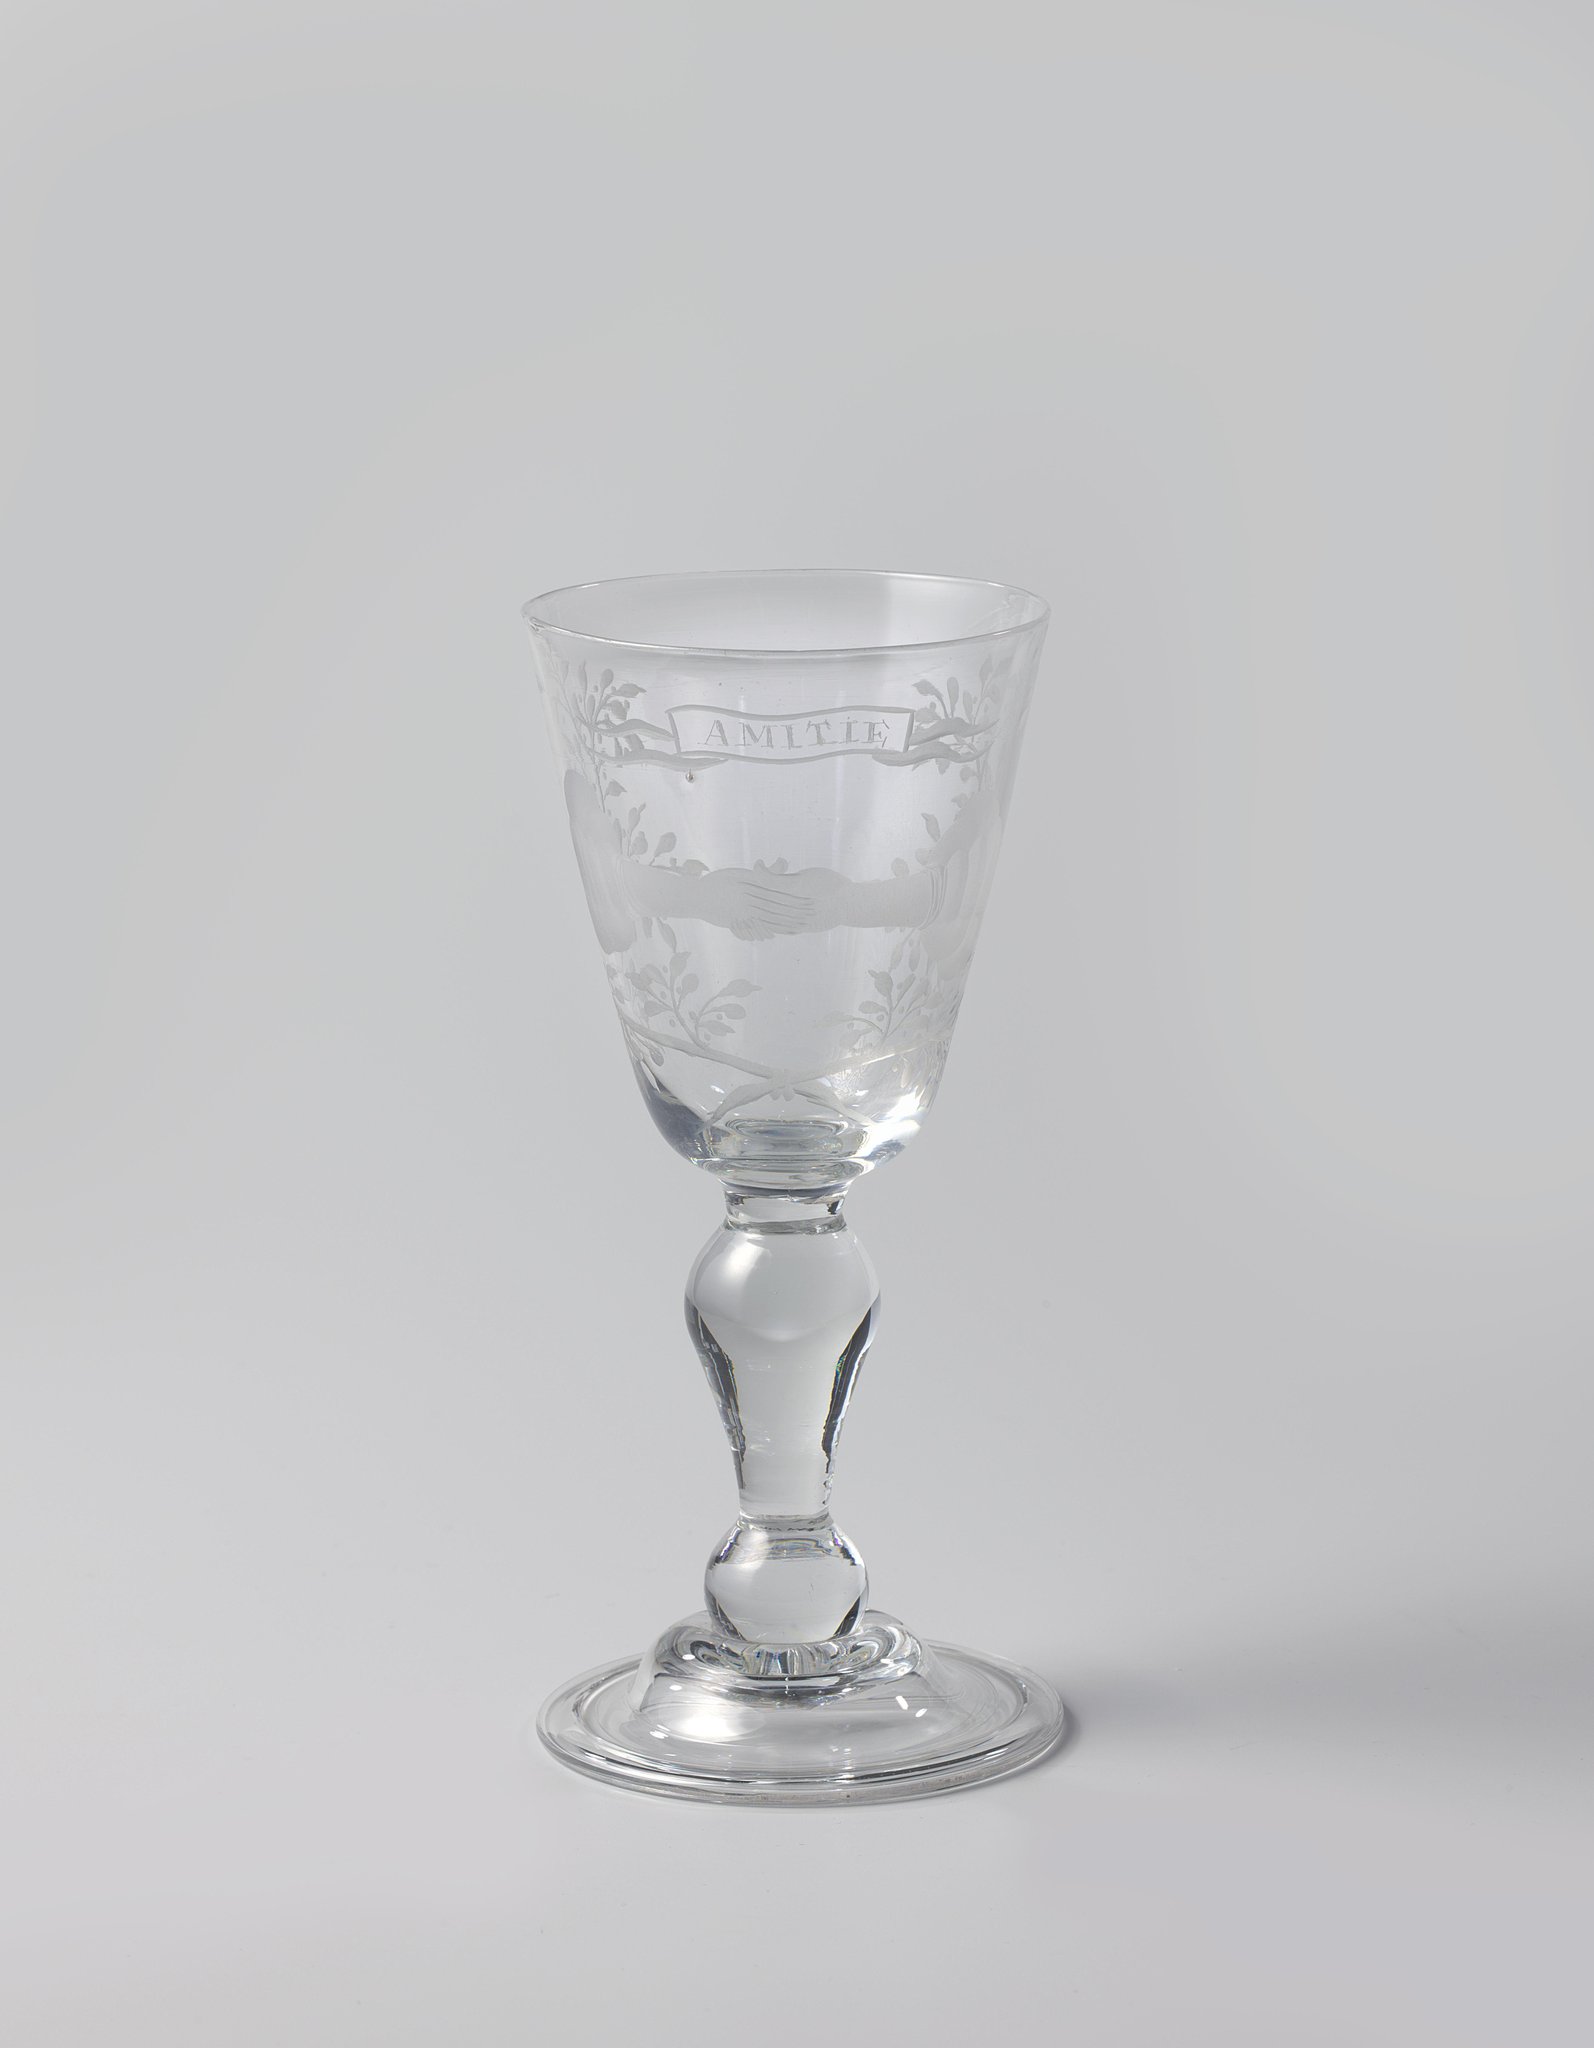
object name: goblet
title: Kelkglas met twee ineengeslagen handen en het opschrift: AMITIE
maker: Anonymous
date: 1725-1750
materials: glass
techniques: glassblowing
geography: northern netherlands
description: Klokvormig gewelfde voet met omgeslagen rand. Balusterstam met een knoop. Conische kelk met afgeronde bodem. Op de kelk met twee handen tussen takken en daarboven in een banderol: "AMITIE".